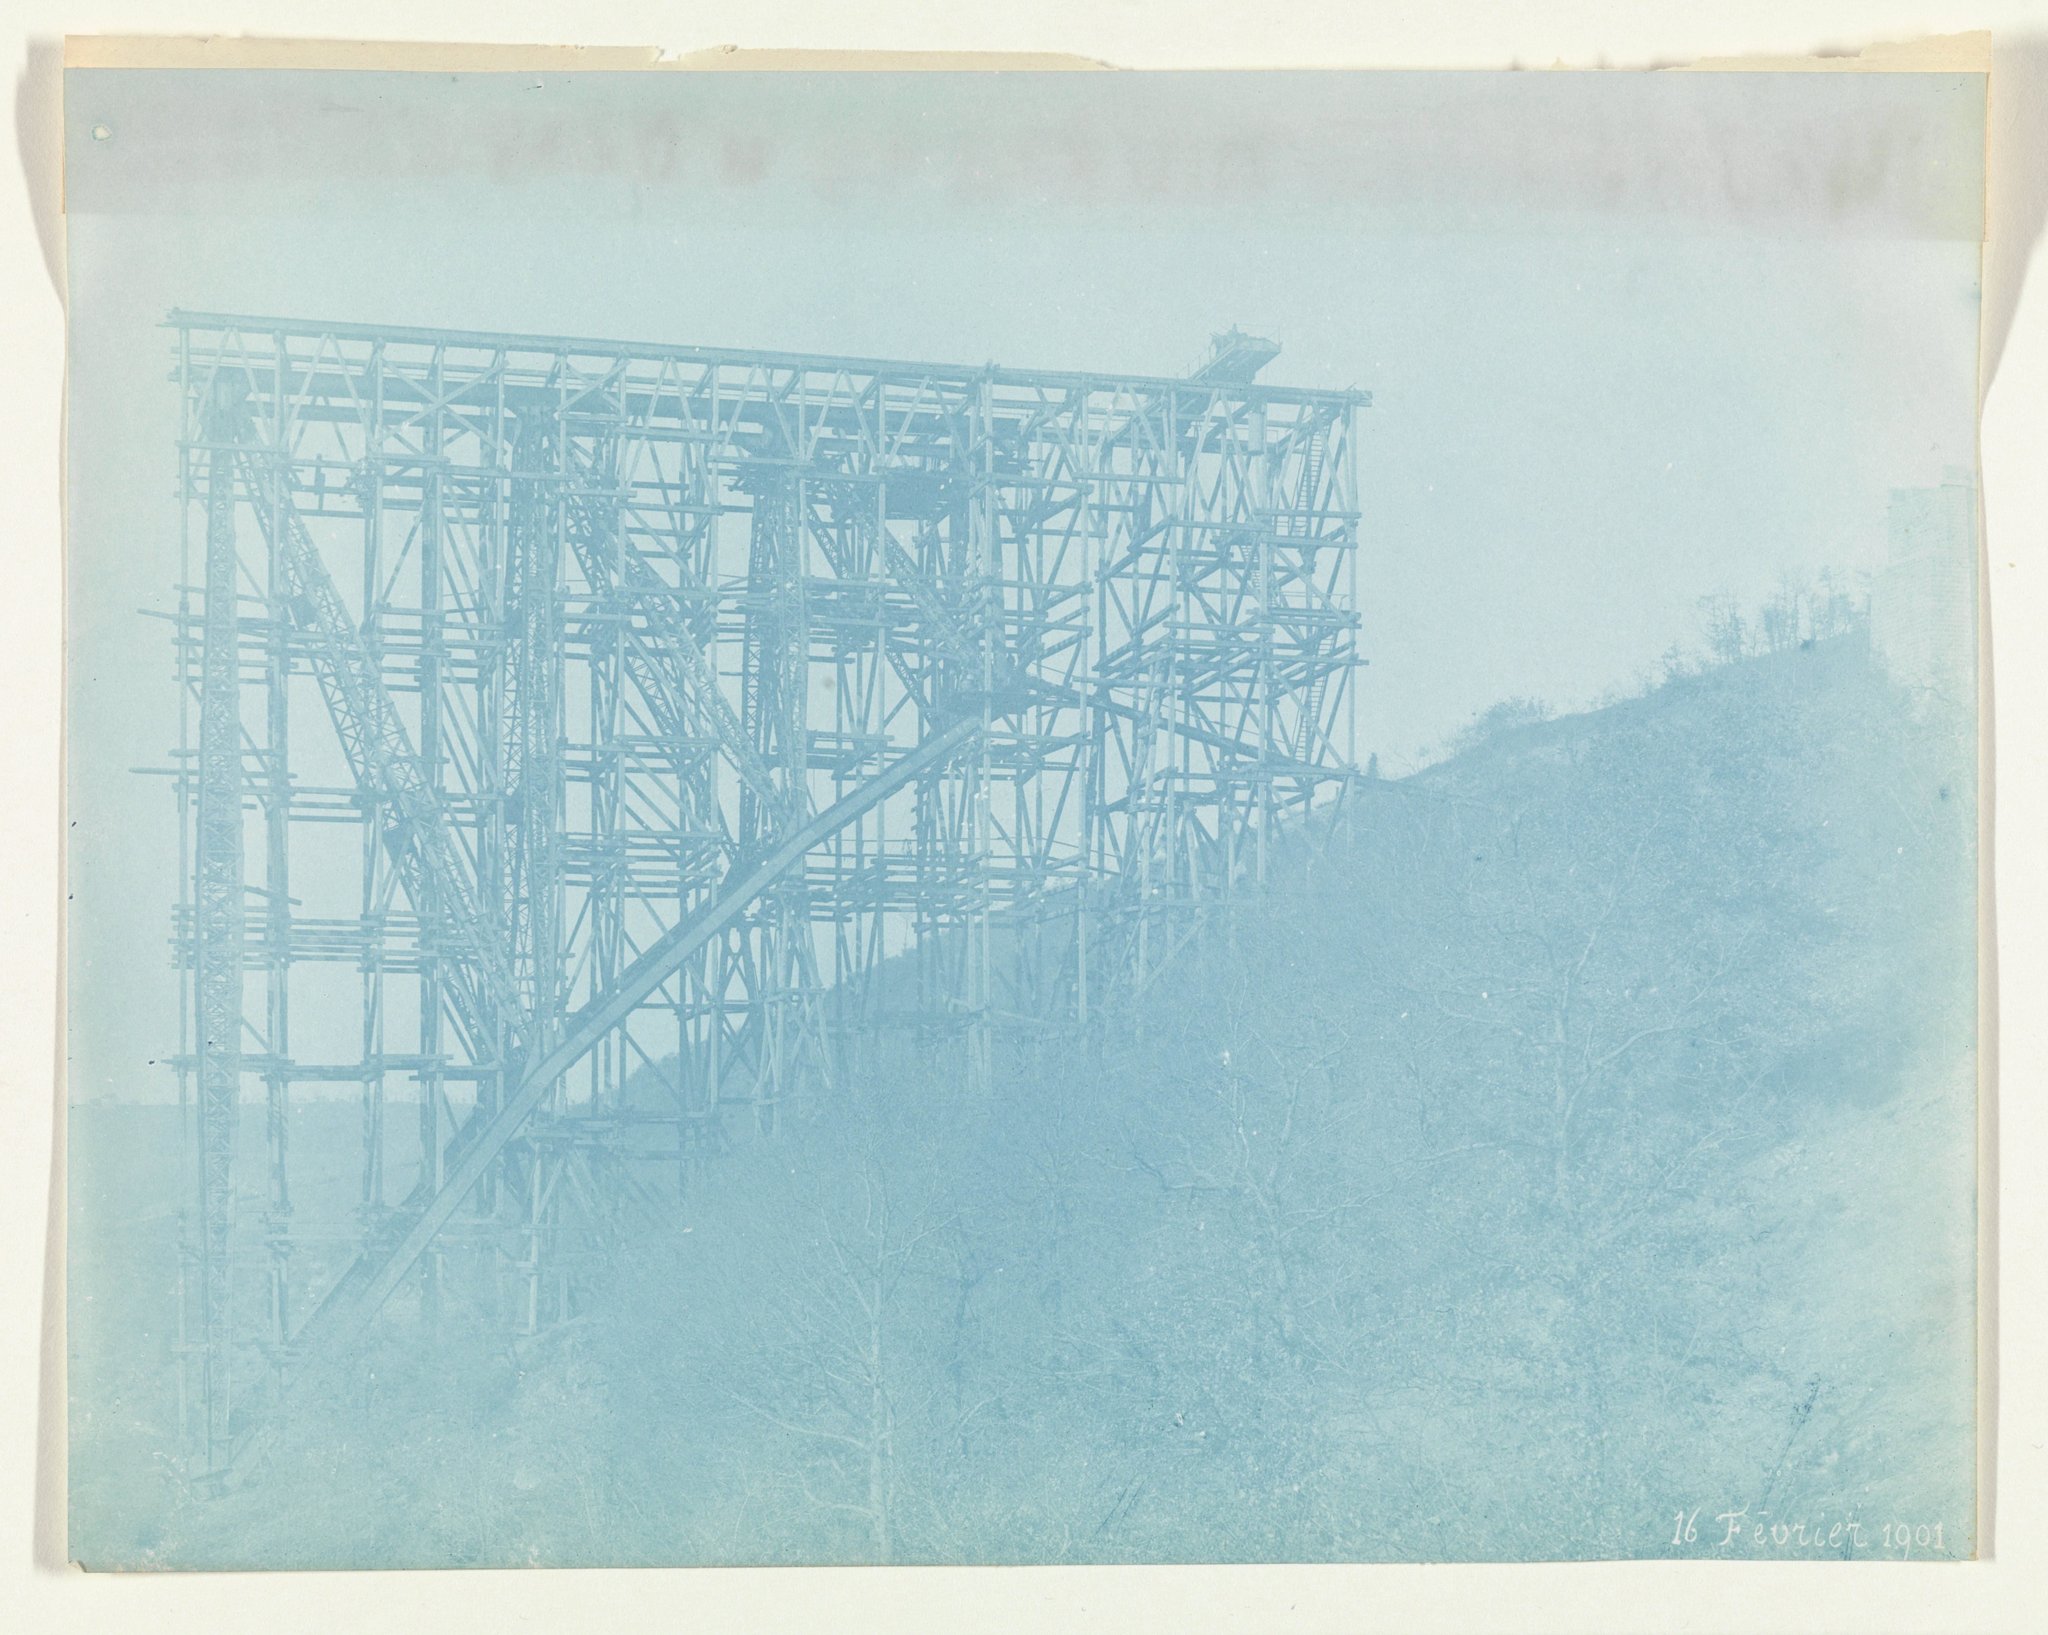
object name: photograph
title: Aanleg van het Viaur Viaduct in Frankrijk door de Societé de Construction des Battignolles, 16 februari 1901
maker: Anonymous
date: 1901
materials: photographic support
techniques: cyanotype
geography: france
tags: viaduct, making the overground structures (~ building activities)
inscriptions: date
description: Op de achterzijde een potloodschets van een deel van de brug.